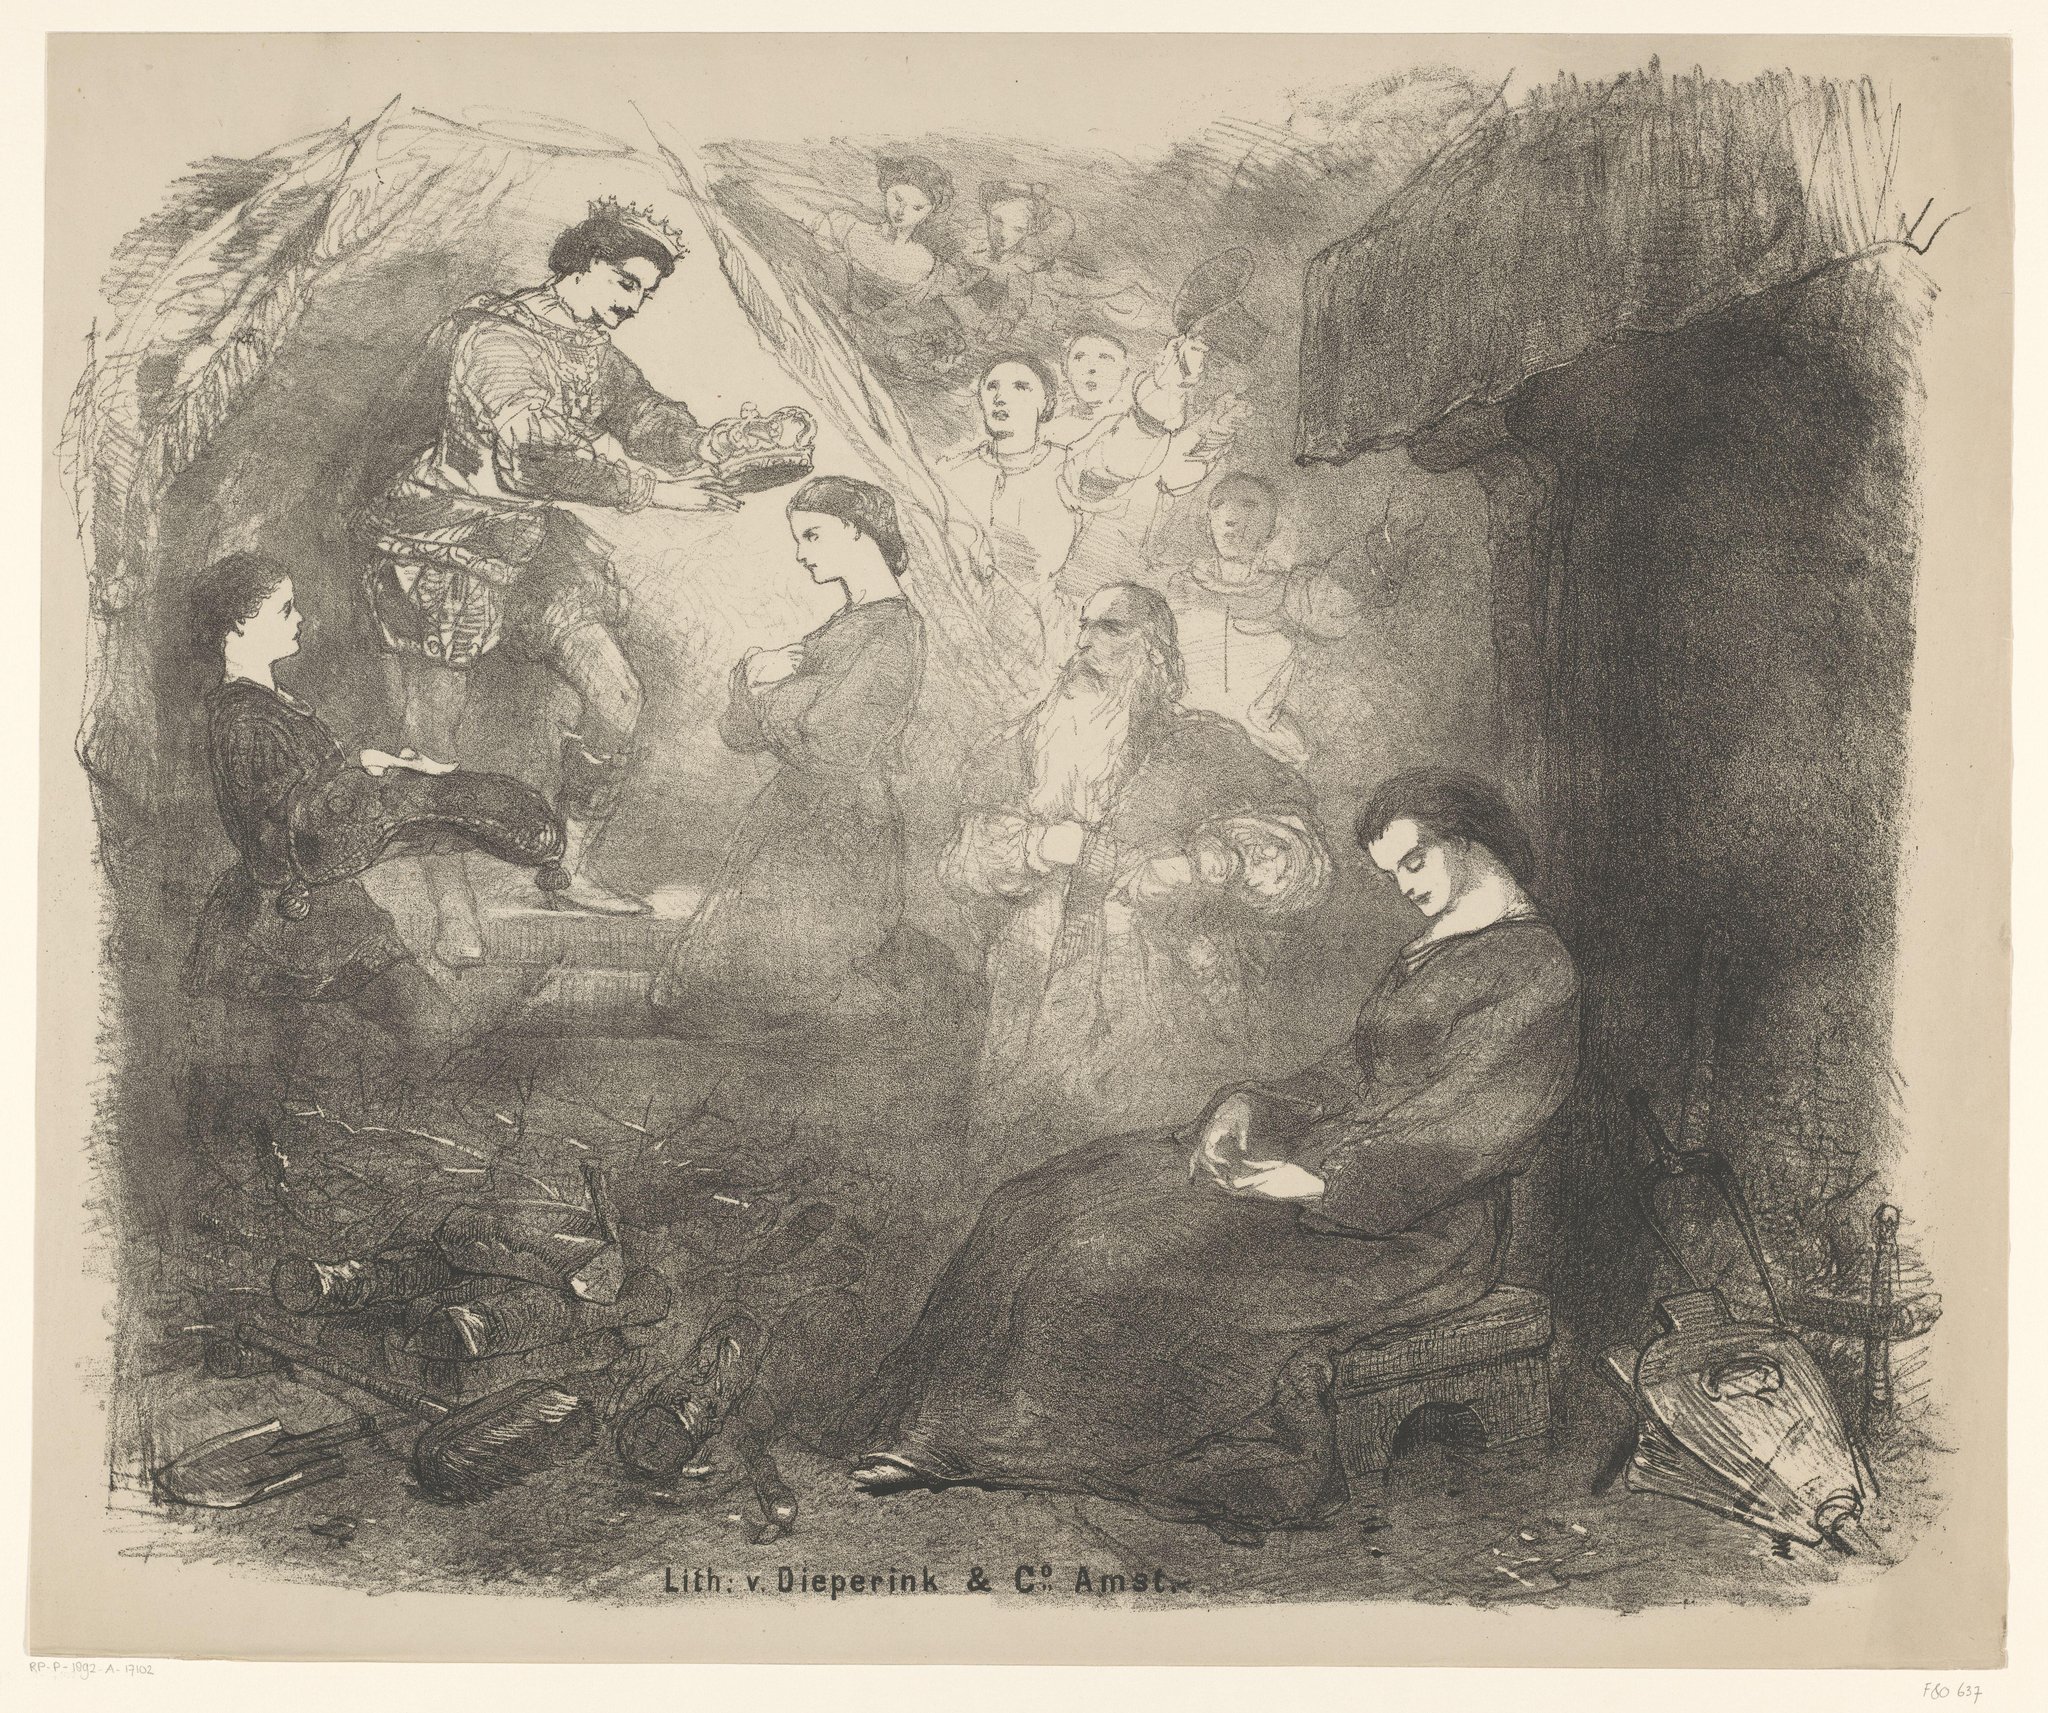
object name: print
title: Aankondigingsbiljetten van balletten en toneelstukken opgevoerd in de Amsterdamse Stadsschouwburg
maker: charles rochussen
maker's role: draughtsman, painter, print maker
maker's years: 1814-1894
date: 1865-1868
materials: paper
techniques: lithograph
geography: amsterdam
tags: theatre, theatrical performance, tales and fairy tales (with title)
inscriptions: inscription: ‘Asschepoetster’, collector's mark: Lugt 2228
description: Op de voorgrond zit Assepoester in een donkere ruimte. Bij haar voeten liggen houtblokken, een schop en bezem. In de achtergrond wordt Assepoester gekroond door de prins. Links staat een bediende met een kussen waarop de verloren schoen van Assepoester staat. Rechts bejubelen figuren de prins en zijn vrouw.